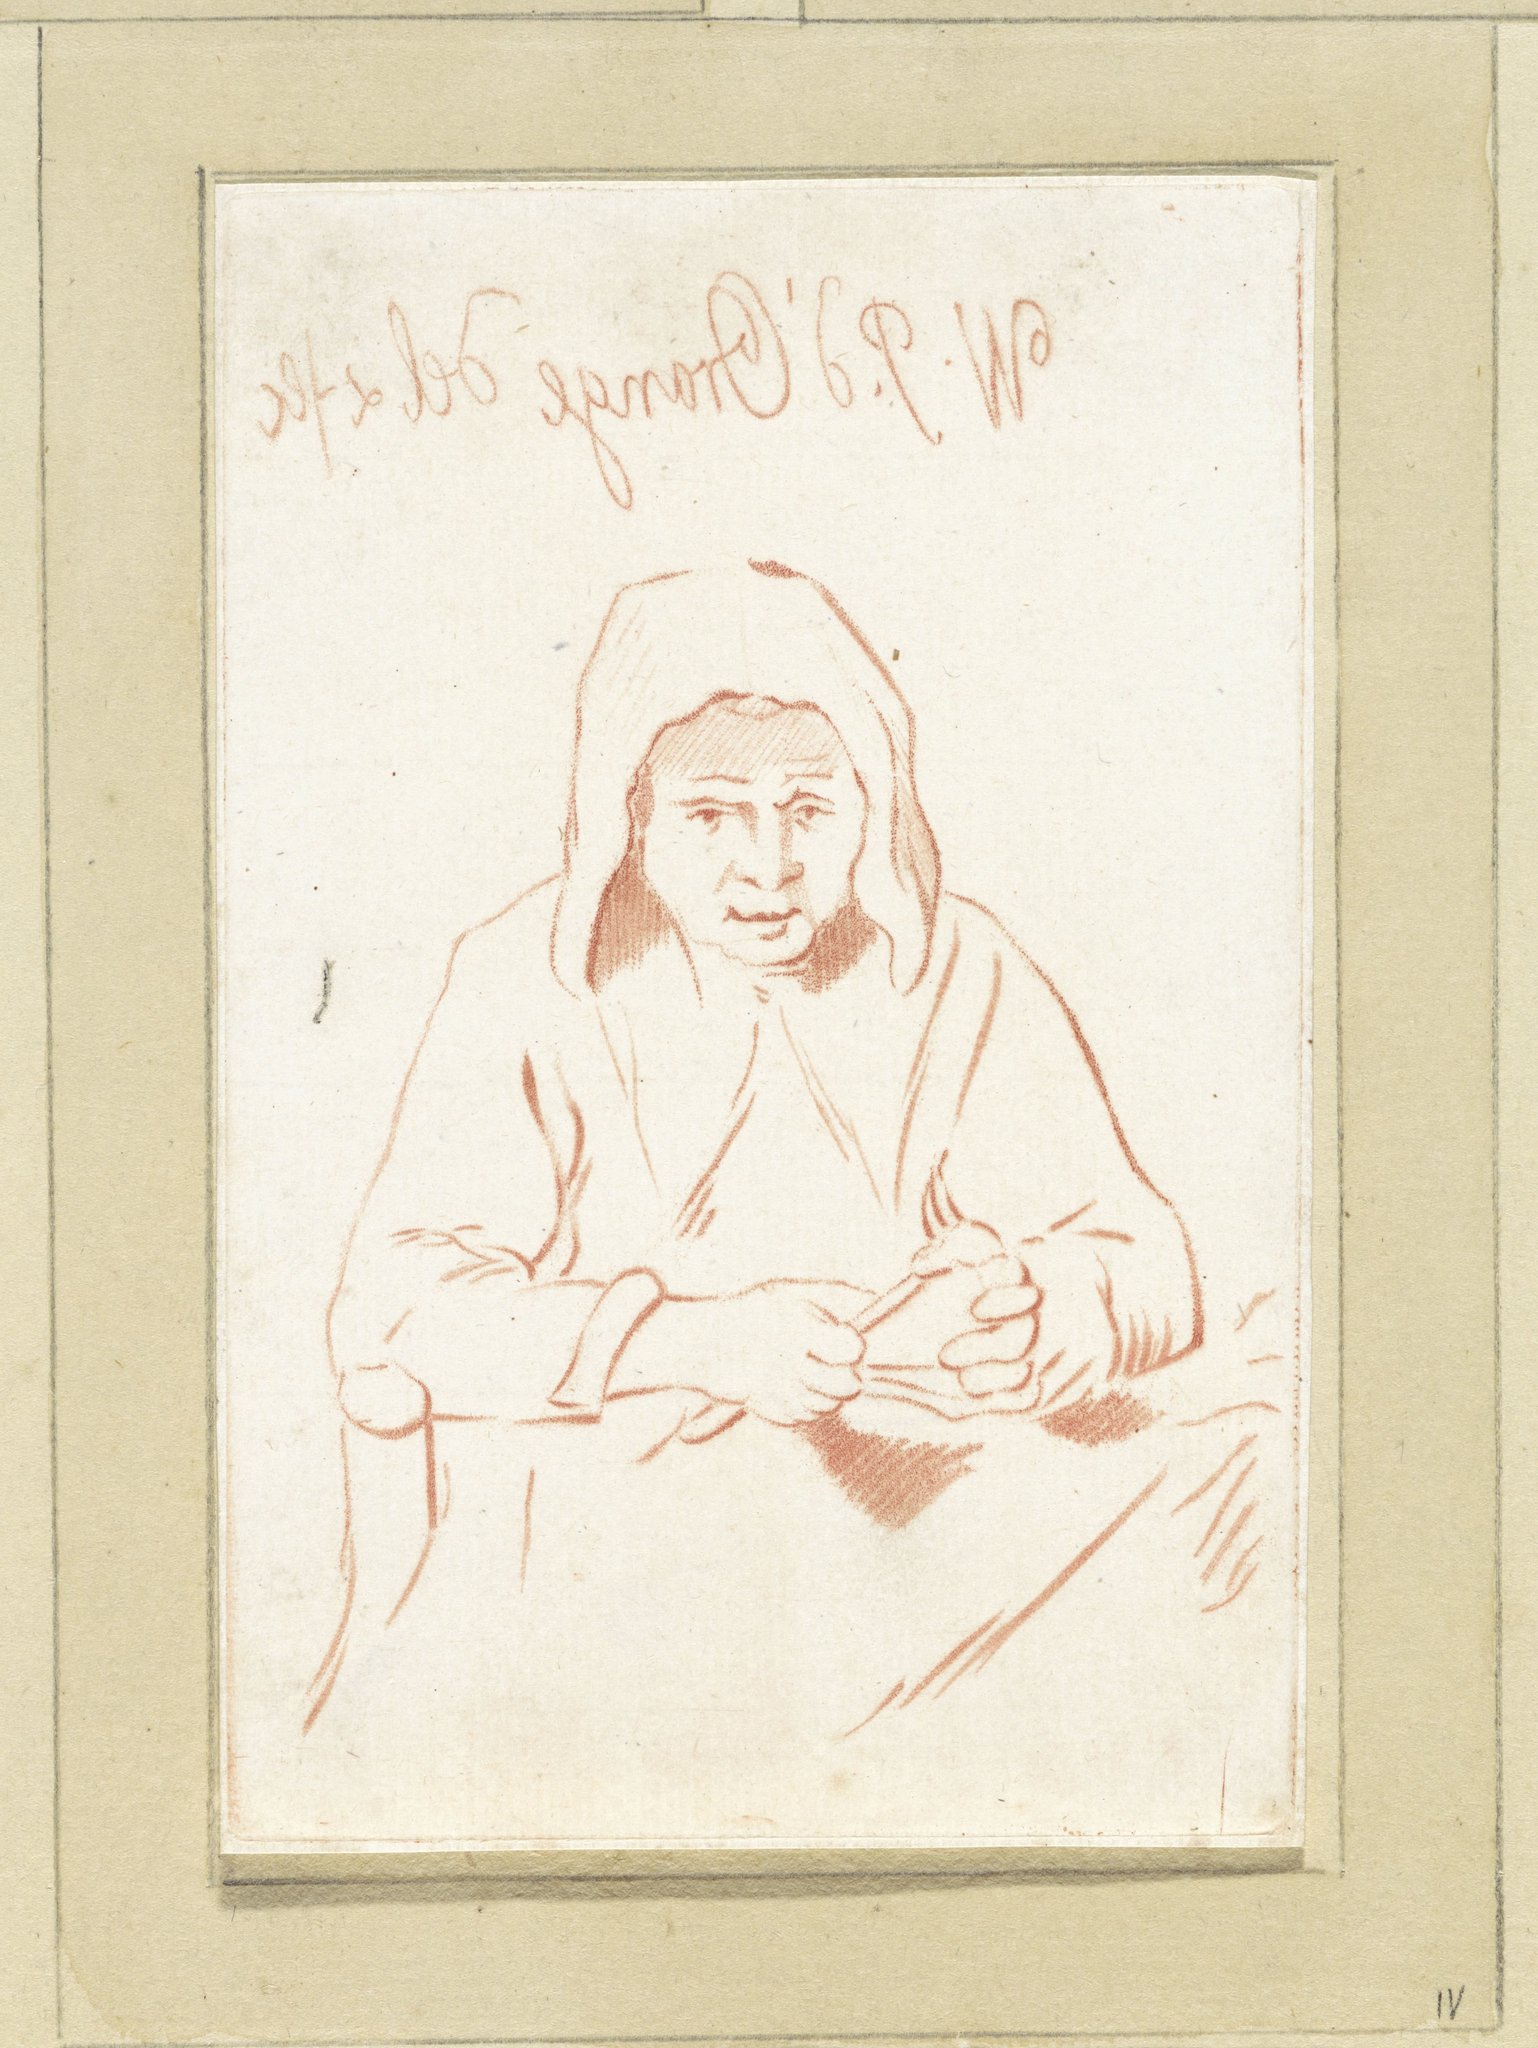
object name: print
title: Zittende oude vrouw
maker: william v (prince of orange)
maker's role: stadhouder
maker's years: 1748-1806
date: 1773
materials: paper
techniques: aquatint, printmaking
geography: the hague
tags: old woman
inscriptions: collector's mark: Lugt 2760, collector's mark: Lugt 2228